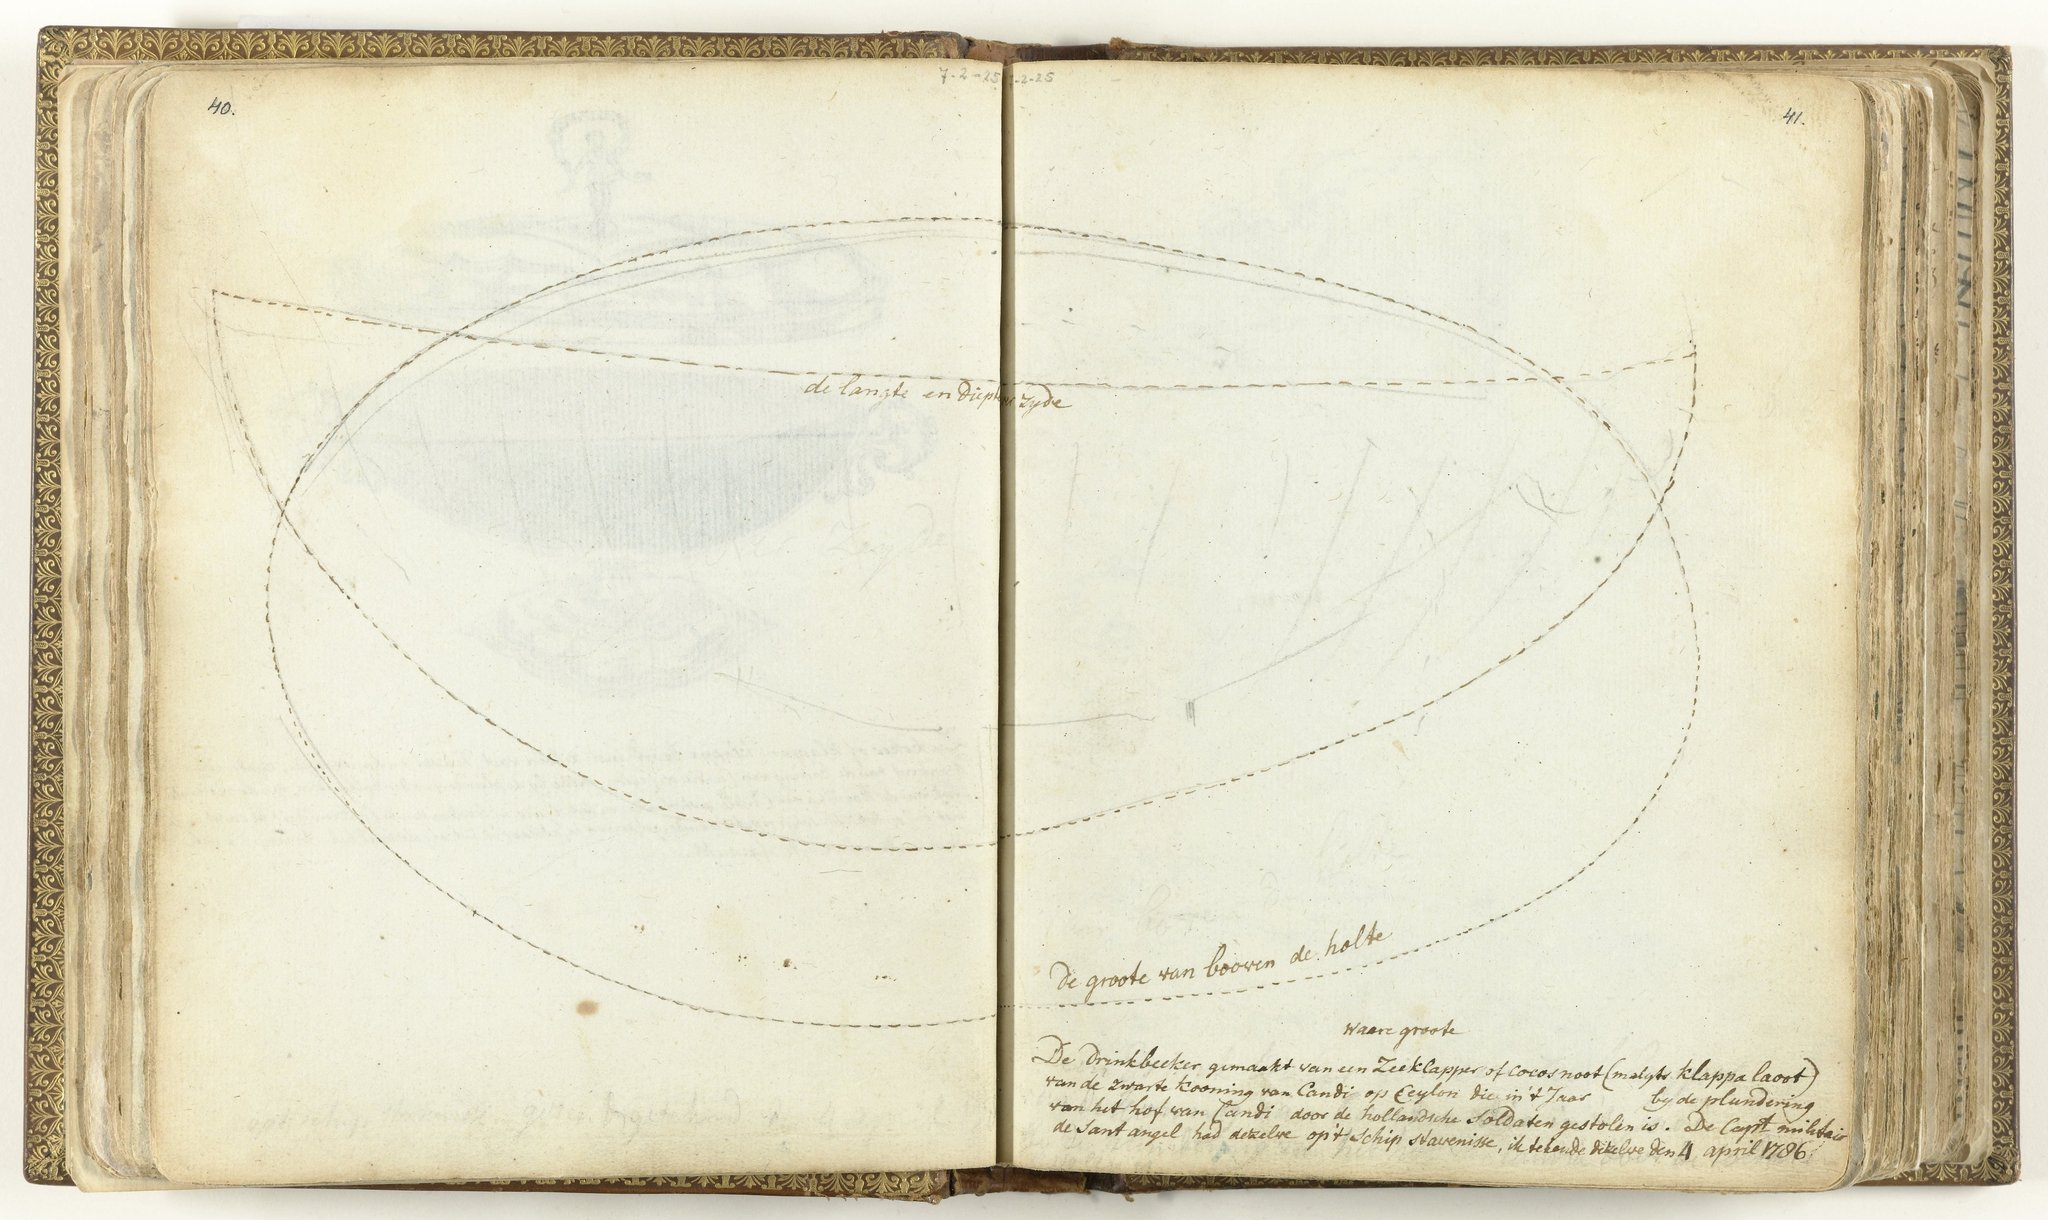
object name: drawing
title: Doorsnedes van drinkvat van de koning van Kandy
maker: jan brandes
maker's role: draughtsman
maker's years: 1743-1808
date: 1786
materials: ink, paper, pencil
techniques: pen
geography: indian ocean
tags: drinking-vessels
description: Pentekening over twee pagina's van de drinkschaal van de koning van Kandy. De tekenaar heeft met stippellijnen de doorsnede en de omvang van de schaal getekend. Met opschrift. Onderdeel uit het schetsboek van Jan Brandes, dl. 2 (1808), p. 40-41 en zie p. 39, 42-44.